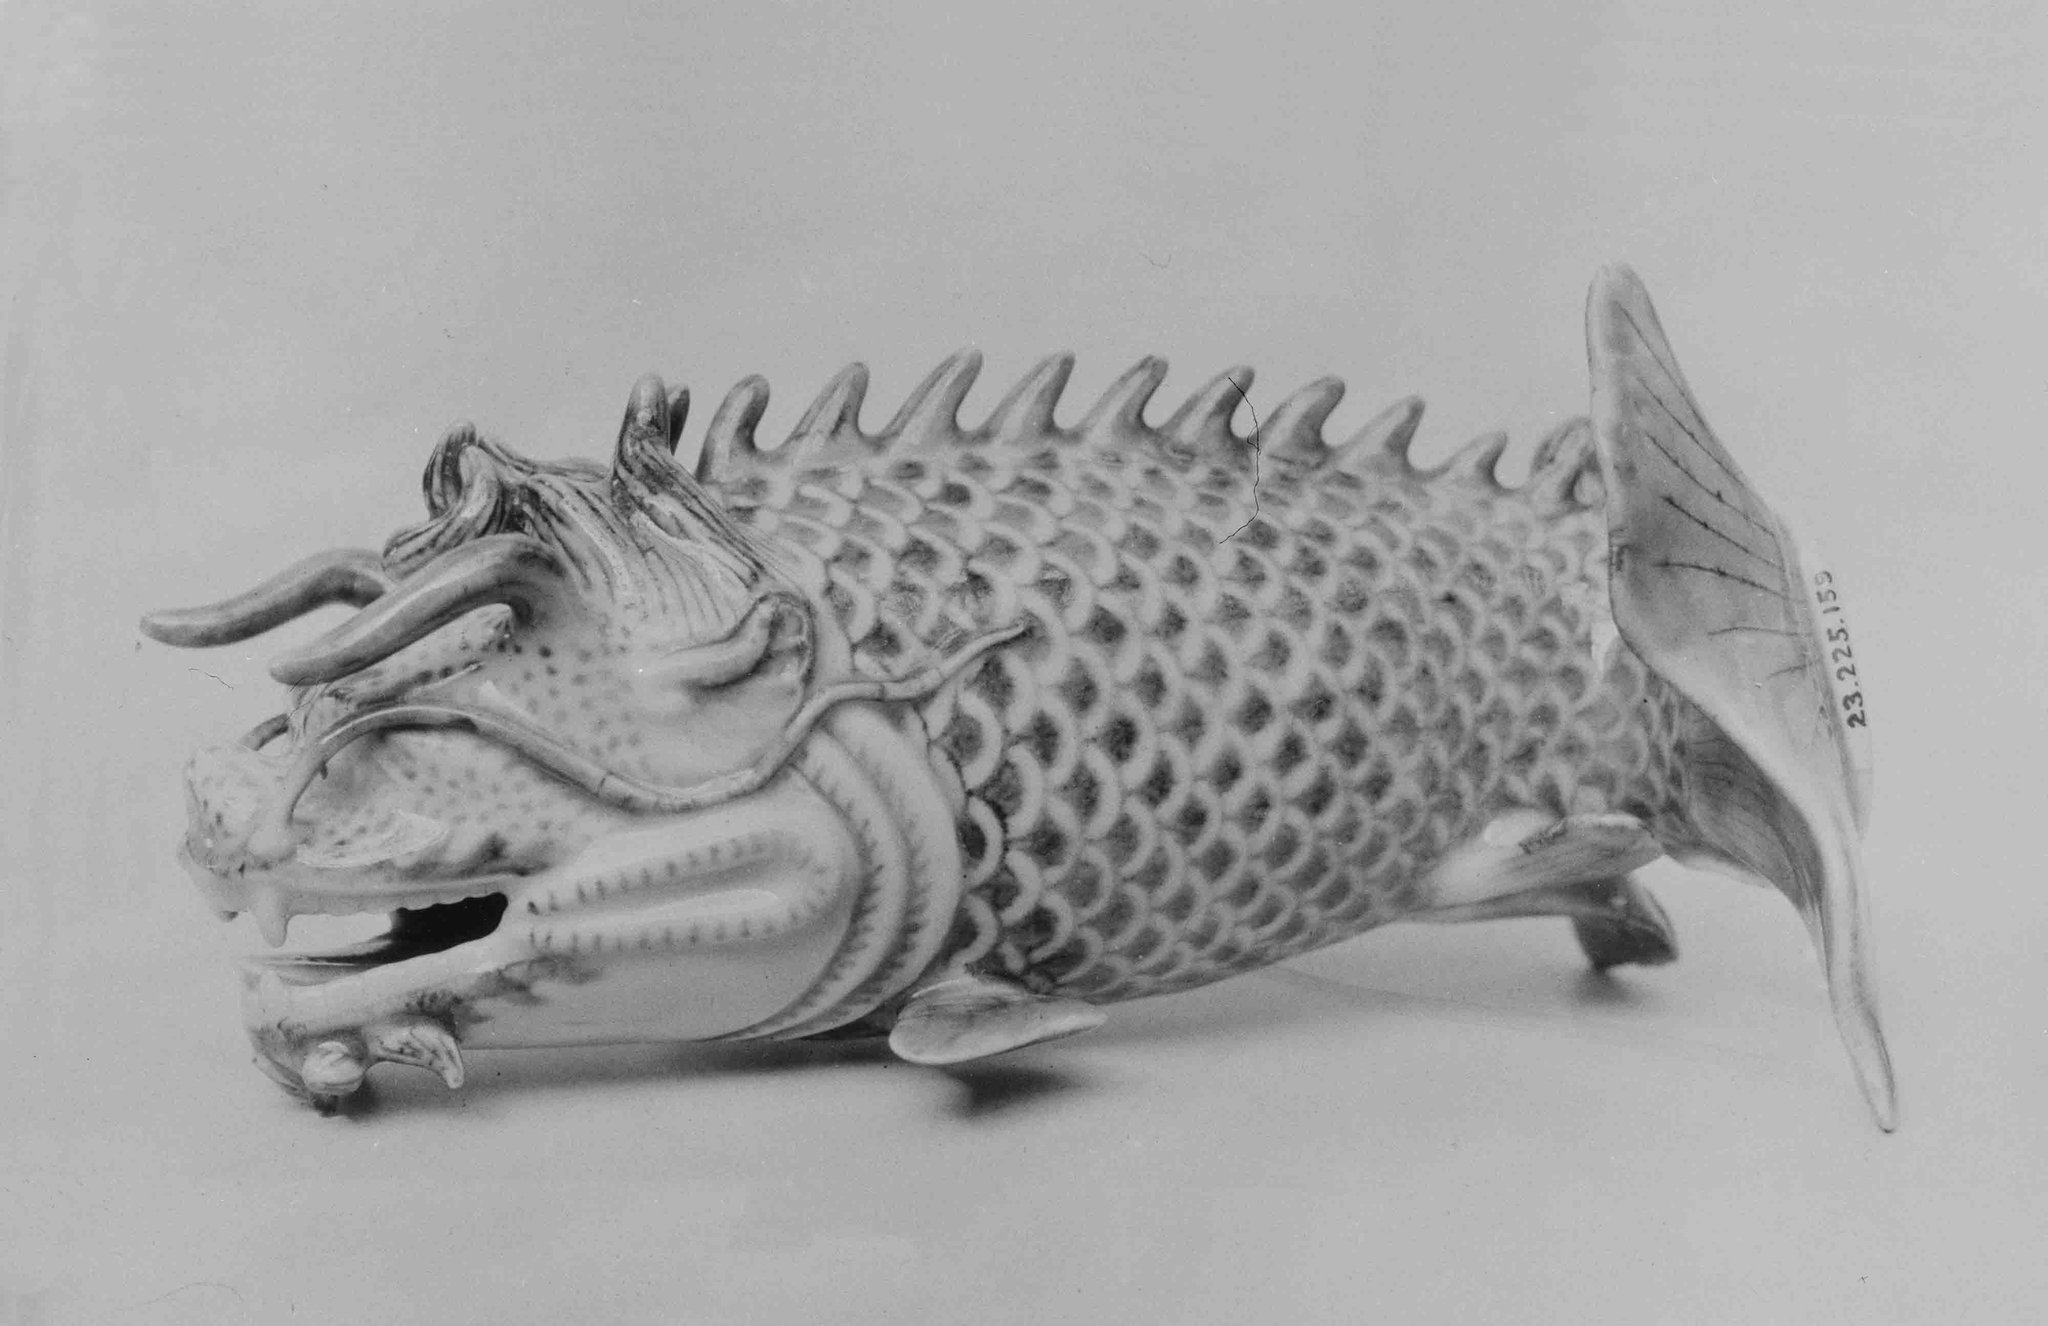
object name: vase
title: Vase in form of a Carp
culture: japanese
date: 1780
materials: glaze, porcelain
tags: fish